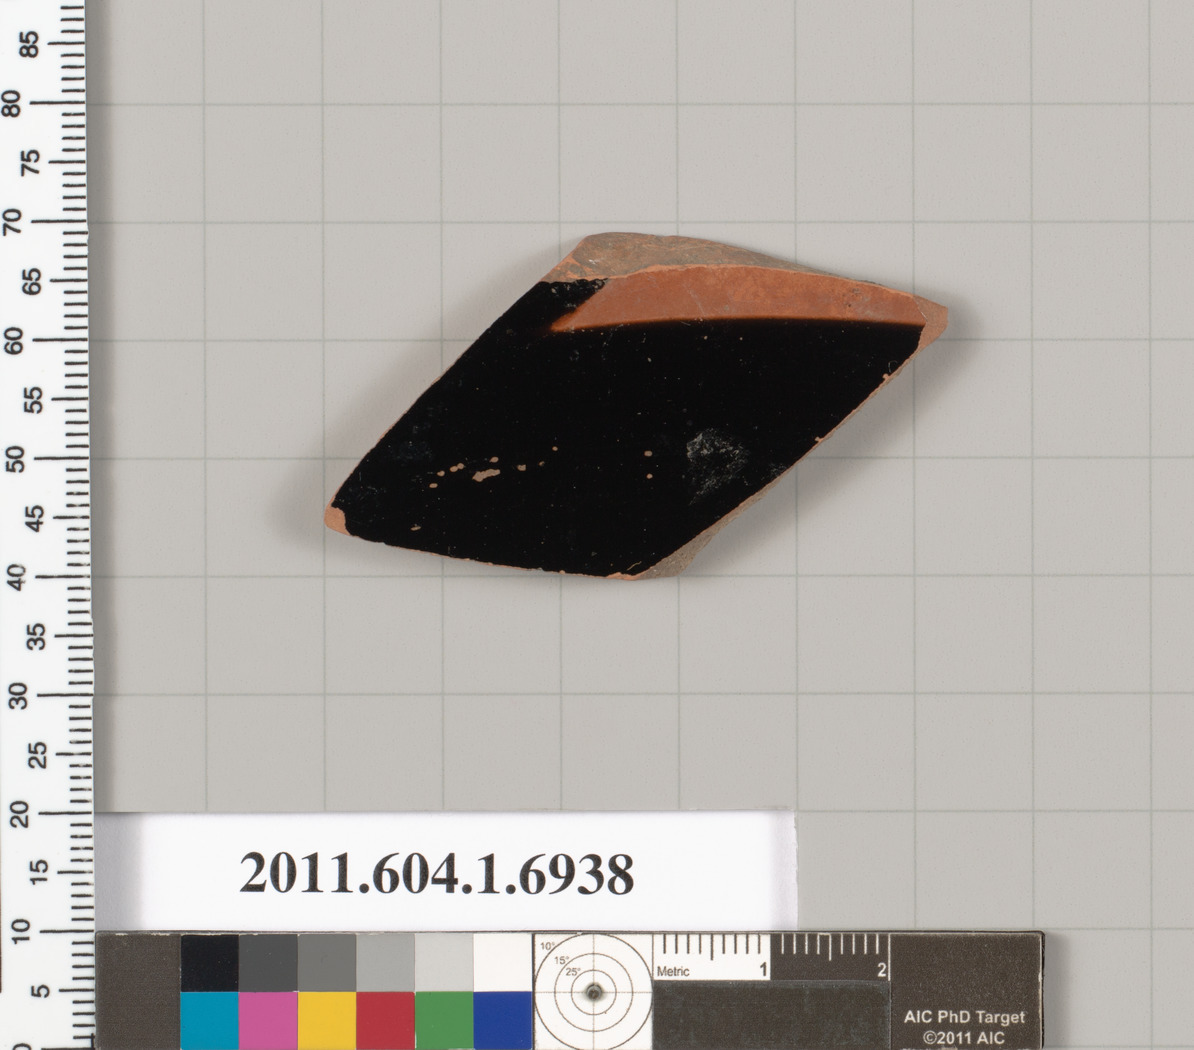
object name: kylix fragment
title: Terracotta fragment of a kylix (drinking cup)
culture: greek, attic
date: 490-470 BCE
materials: terracotta